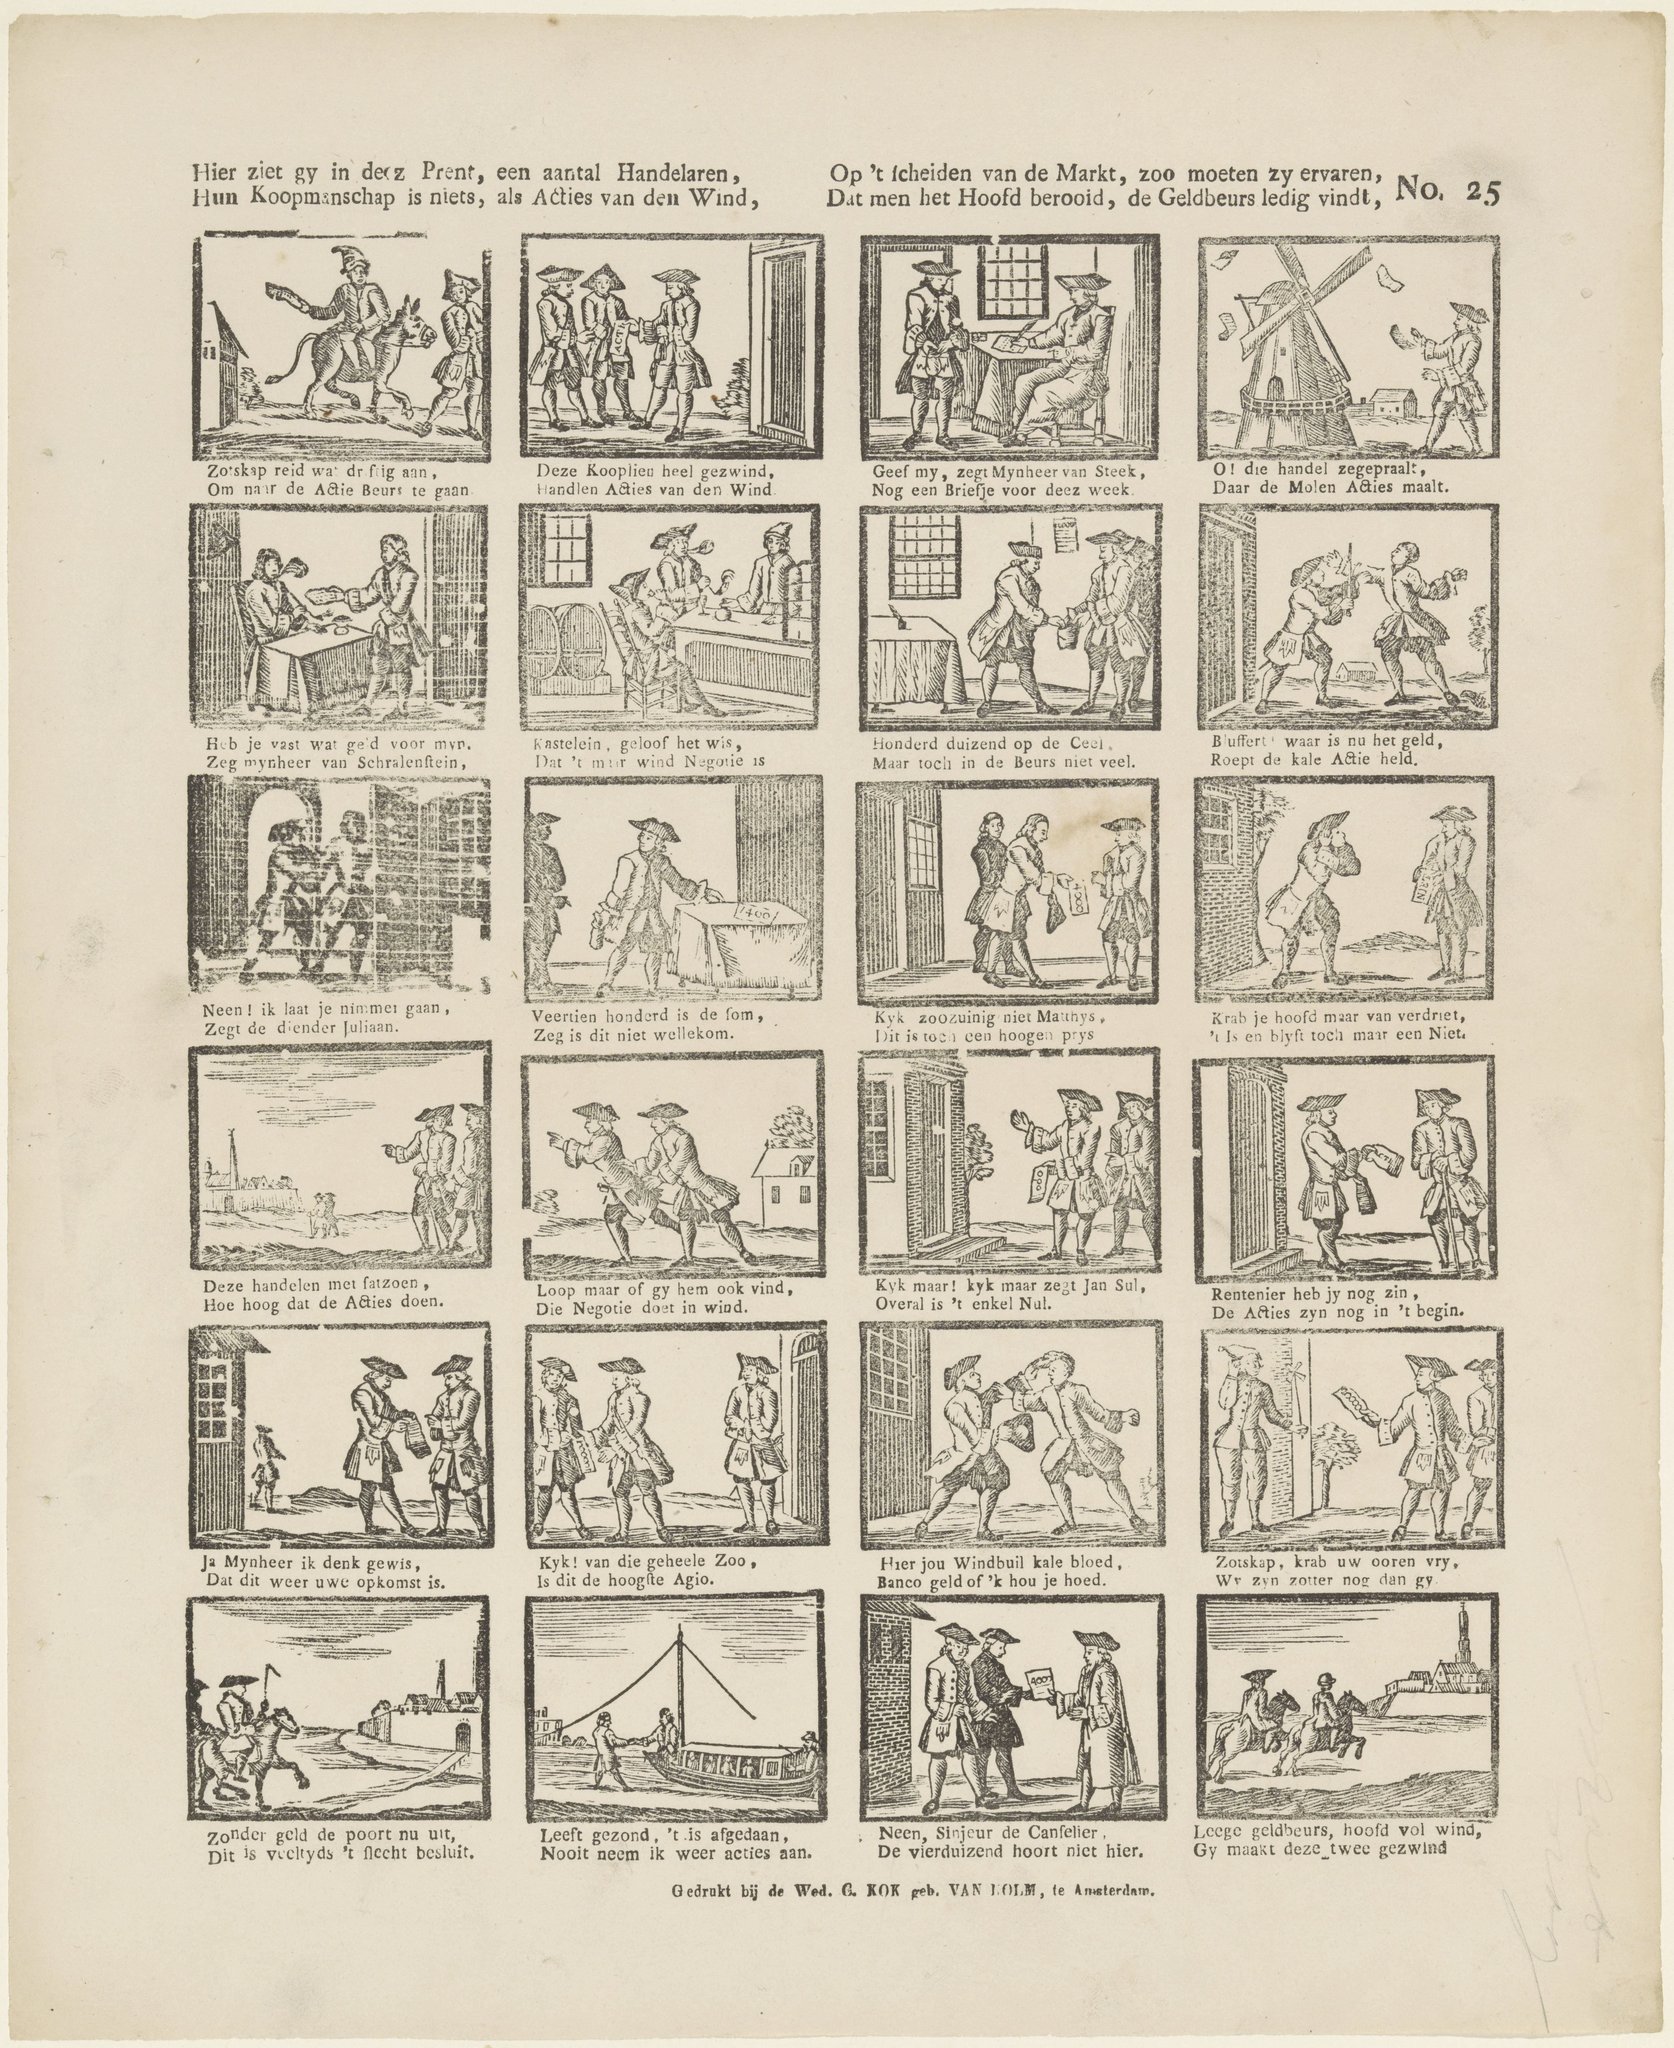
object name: print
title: Hier ziet gy in deze prent, een aantal handelaren, / Hun koopmanschap is niets, als acties van den wind, / Op 't scheiden van de markt, zoo moeten zy ervaren, / Dat men het hoofd berooid, de geldbeurs ledig vindt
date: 1842-1866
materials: paper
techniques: letterpress printing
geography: amsterdam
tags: stock exchange, stock-market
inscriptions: collector's mark: Lugt 2760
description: Blad met 24 voorstellingen van actiehandelaren (aandelenhandelaren) in actie. Onder elke afbeelding een tweeregelig vers. Genummerd rechtsboven: No. 25.